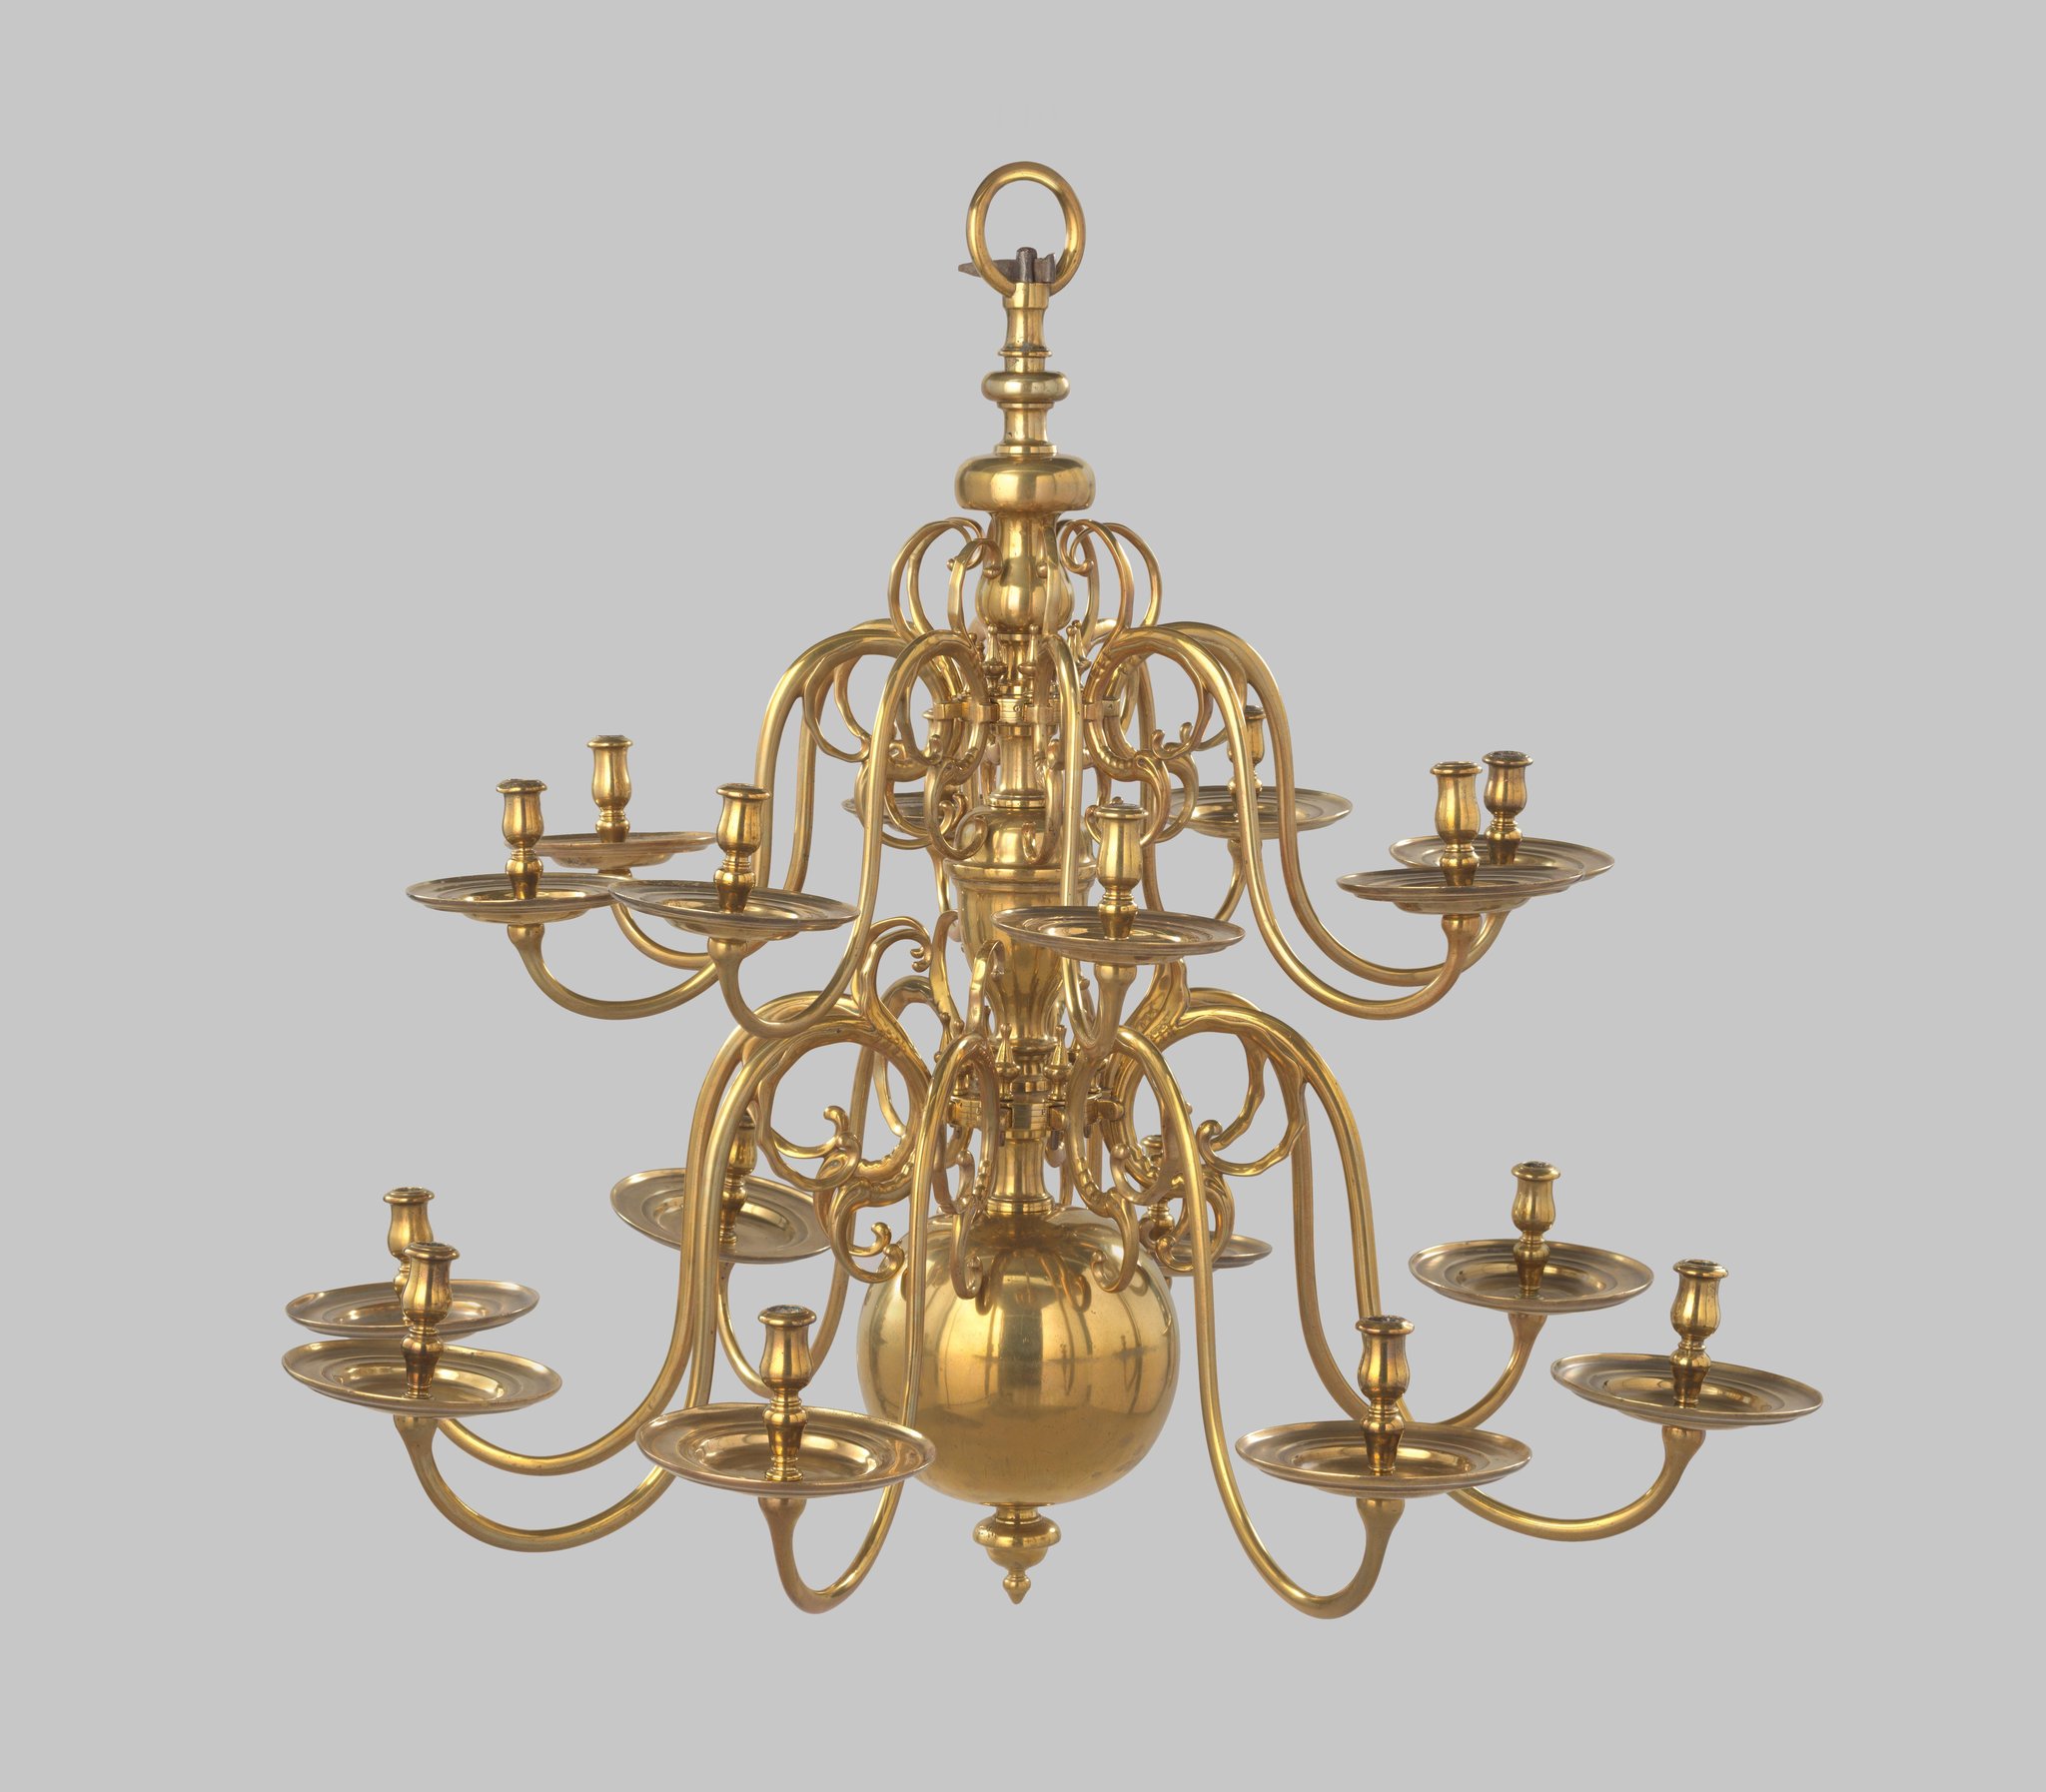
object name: chandelier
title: Arm van een kaarsenkroon in twee hoogten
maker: Anonymous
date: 1650-1675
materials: brass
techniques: screwed, turning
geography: amsterdam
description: De S-vormige arm is aan de stamzijde voorzien van een nok met een opening om deze met een pin in de standring te kunnen vastzetten. Bij de stam is de arm op het eind versierd met een gestileerde dolfijnenkop en met twee krullen, waarvan de vormgeving aan het kwabornament is ontleend. Naar buiten toe eindigt de arm in een verdikking, waarin een van een schroefdraad voorzien gat is aangebracht ter bevestiging van de kaarsenhouder met de vetvanger. De arm is met behulp van hetzelfde model gegoten als de overige armen van de krans en heeft dezelfe grootte. De kaarsenhouder heeft een ronde zich naar boven toe versmallende en in een uitstekende rand overgaande vaasvorm op balustervoet met een van een schroefdraad voorzien eind, waarin onderaan het centergat. De vetvanger is aan de bovenkant naar het midden toe één keer verdiept. Aan de onderkant is zij geprofileerd op de rand en rond het gat op het enigszins bolvormige midden. De vetvanger heeft telkens zijn eigen grootte en is met behulp van hetzelfde model gegoten als de overige vetvangers van deze krans. De pin is voorzien van een knop in vaasvorm. Dit is de achtste arm van de onderste standring, genummerd op de nok met de letter H.